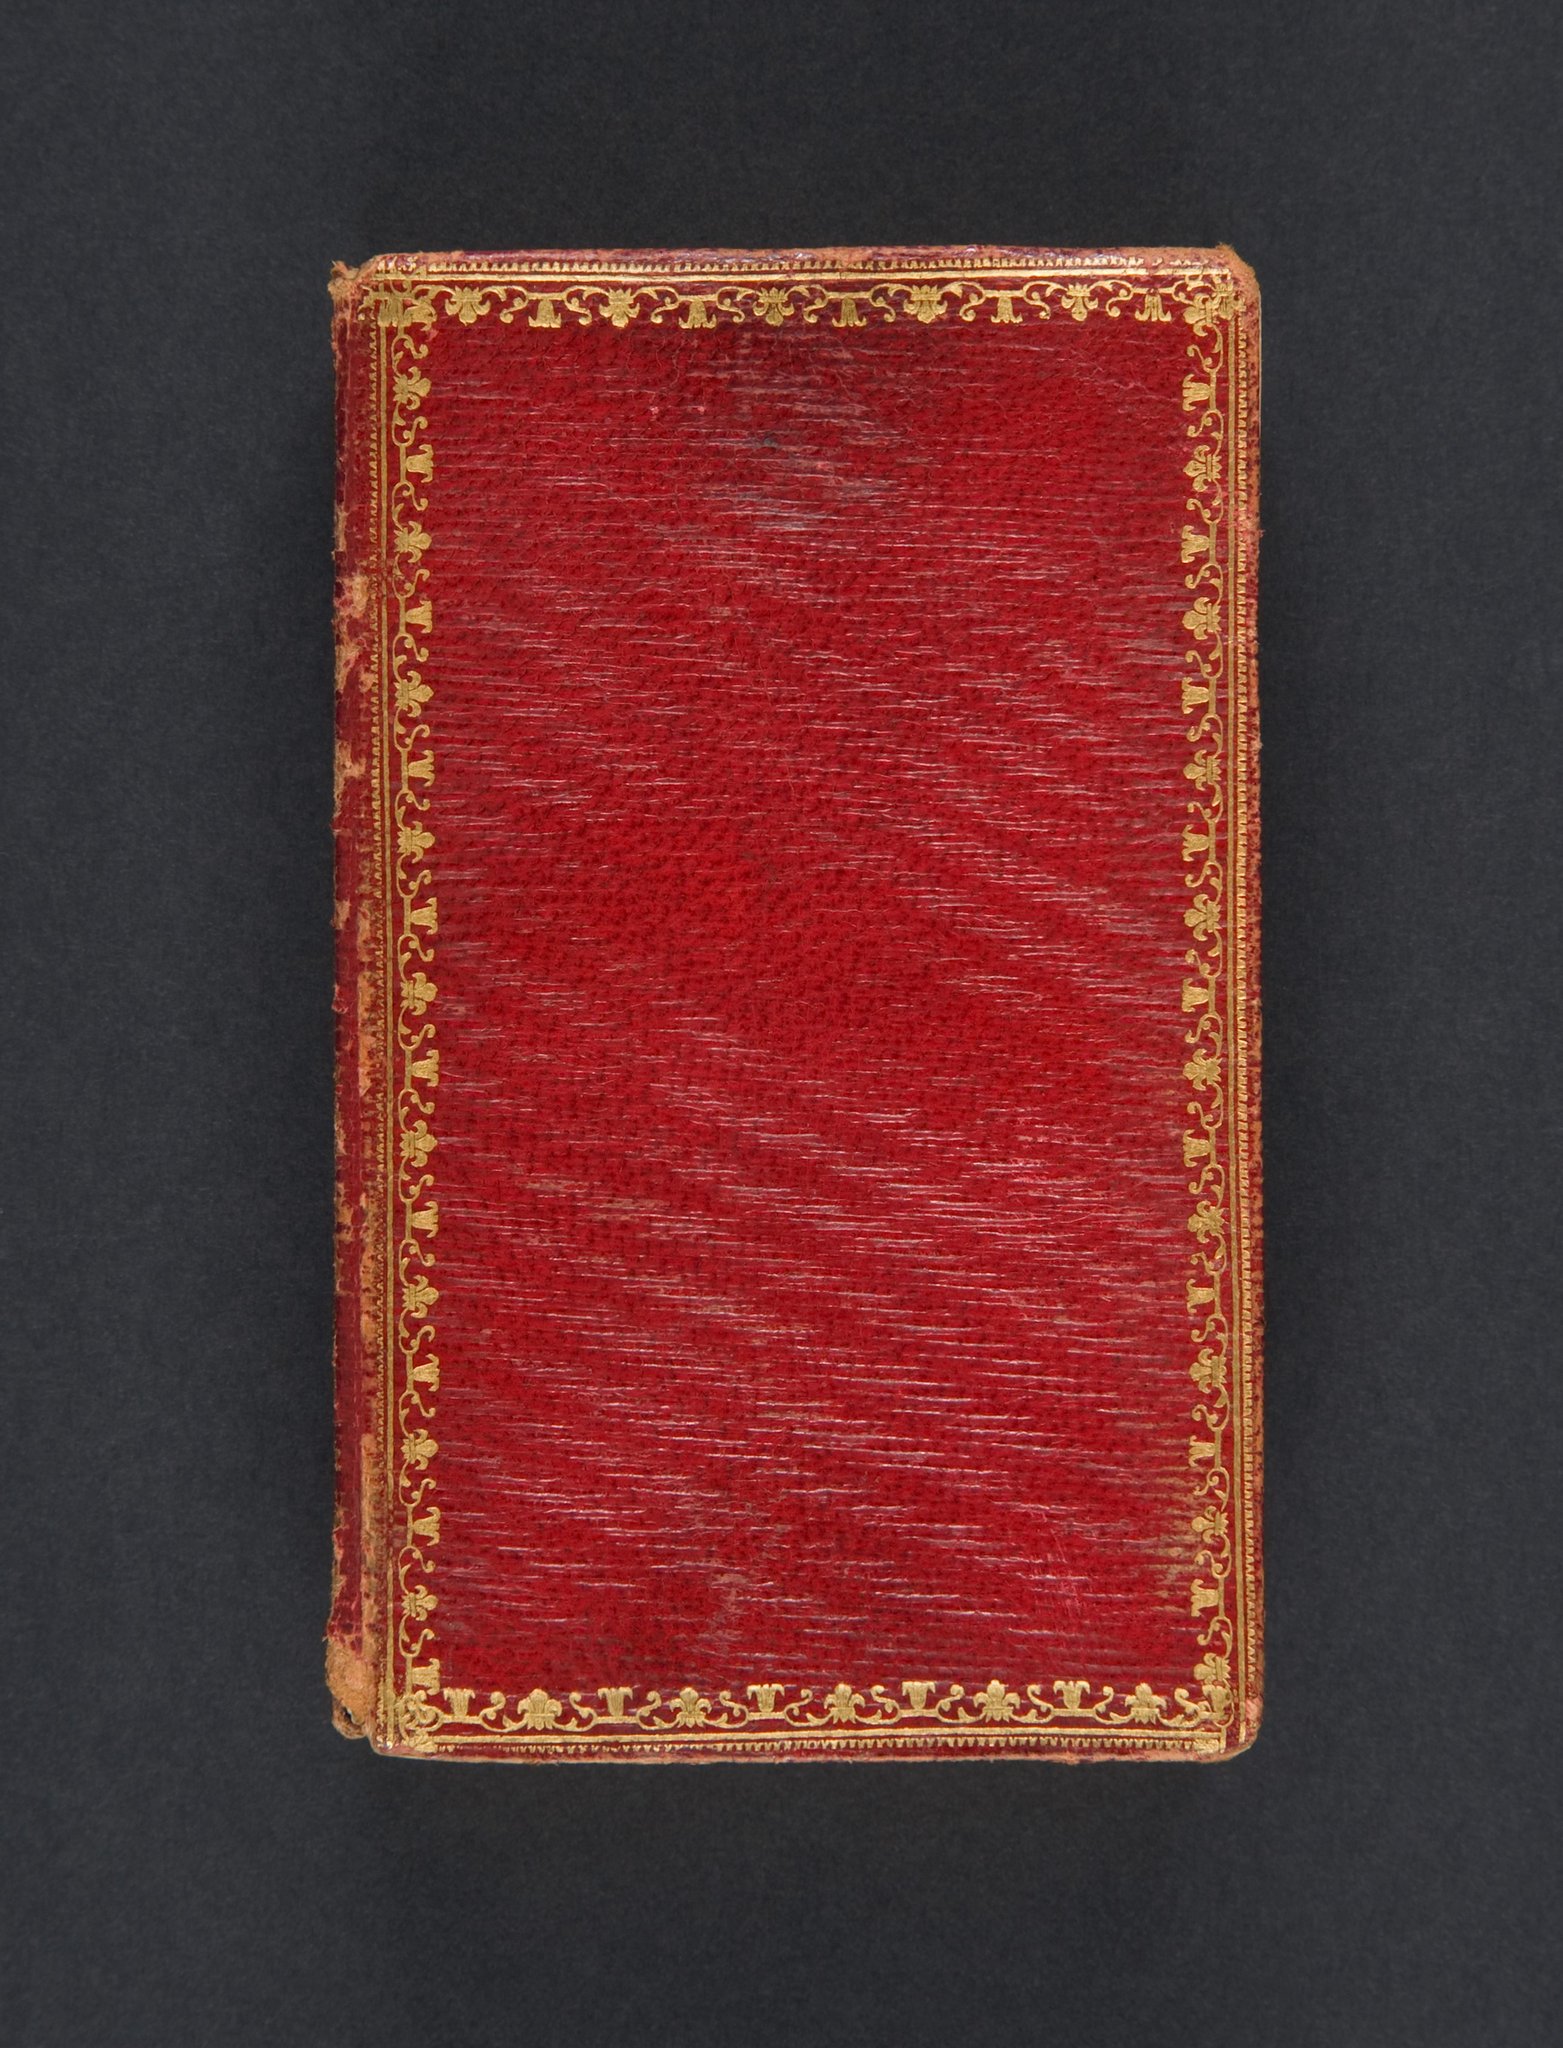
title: Petit almanach de la cour de France : 1819. treizième année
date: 1818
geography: france